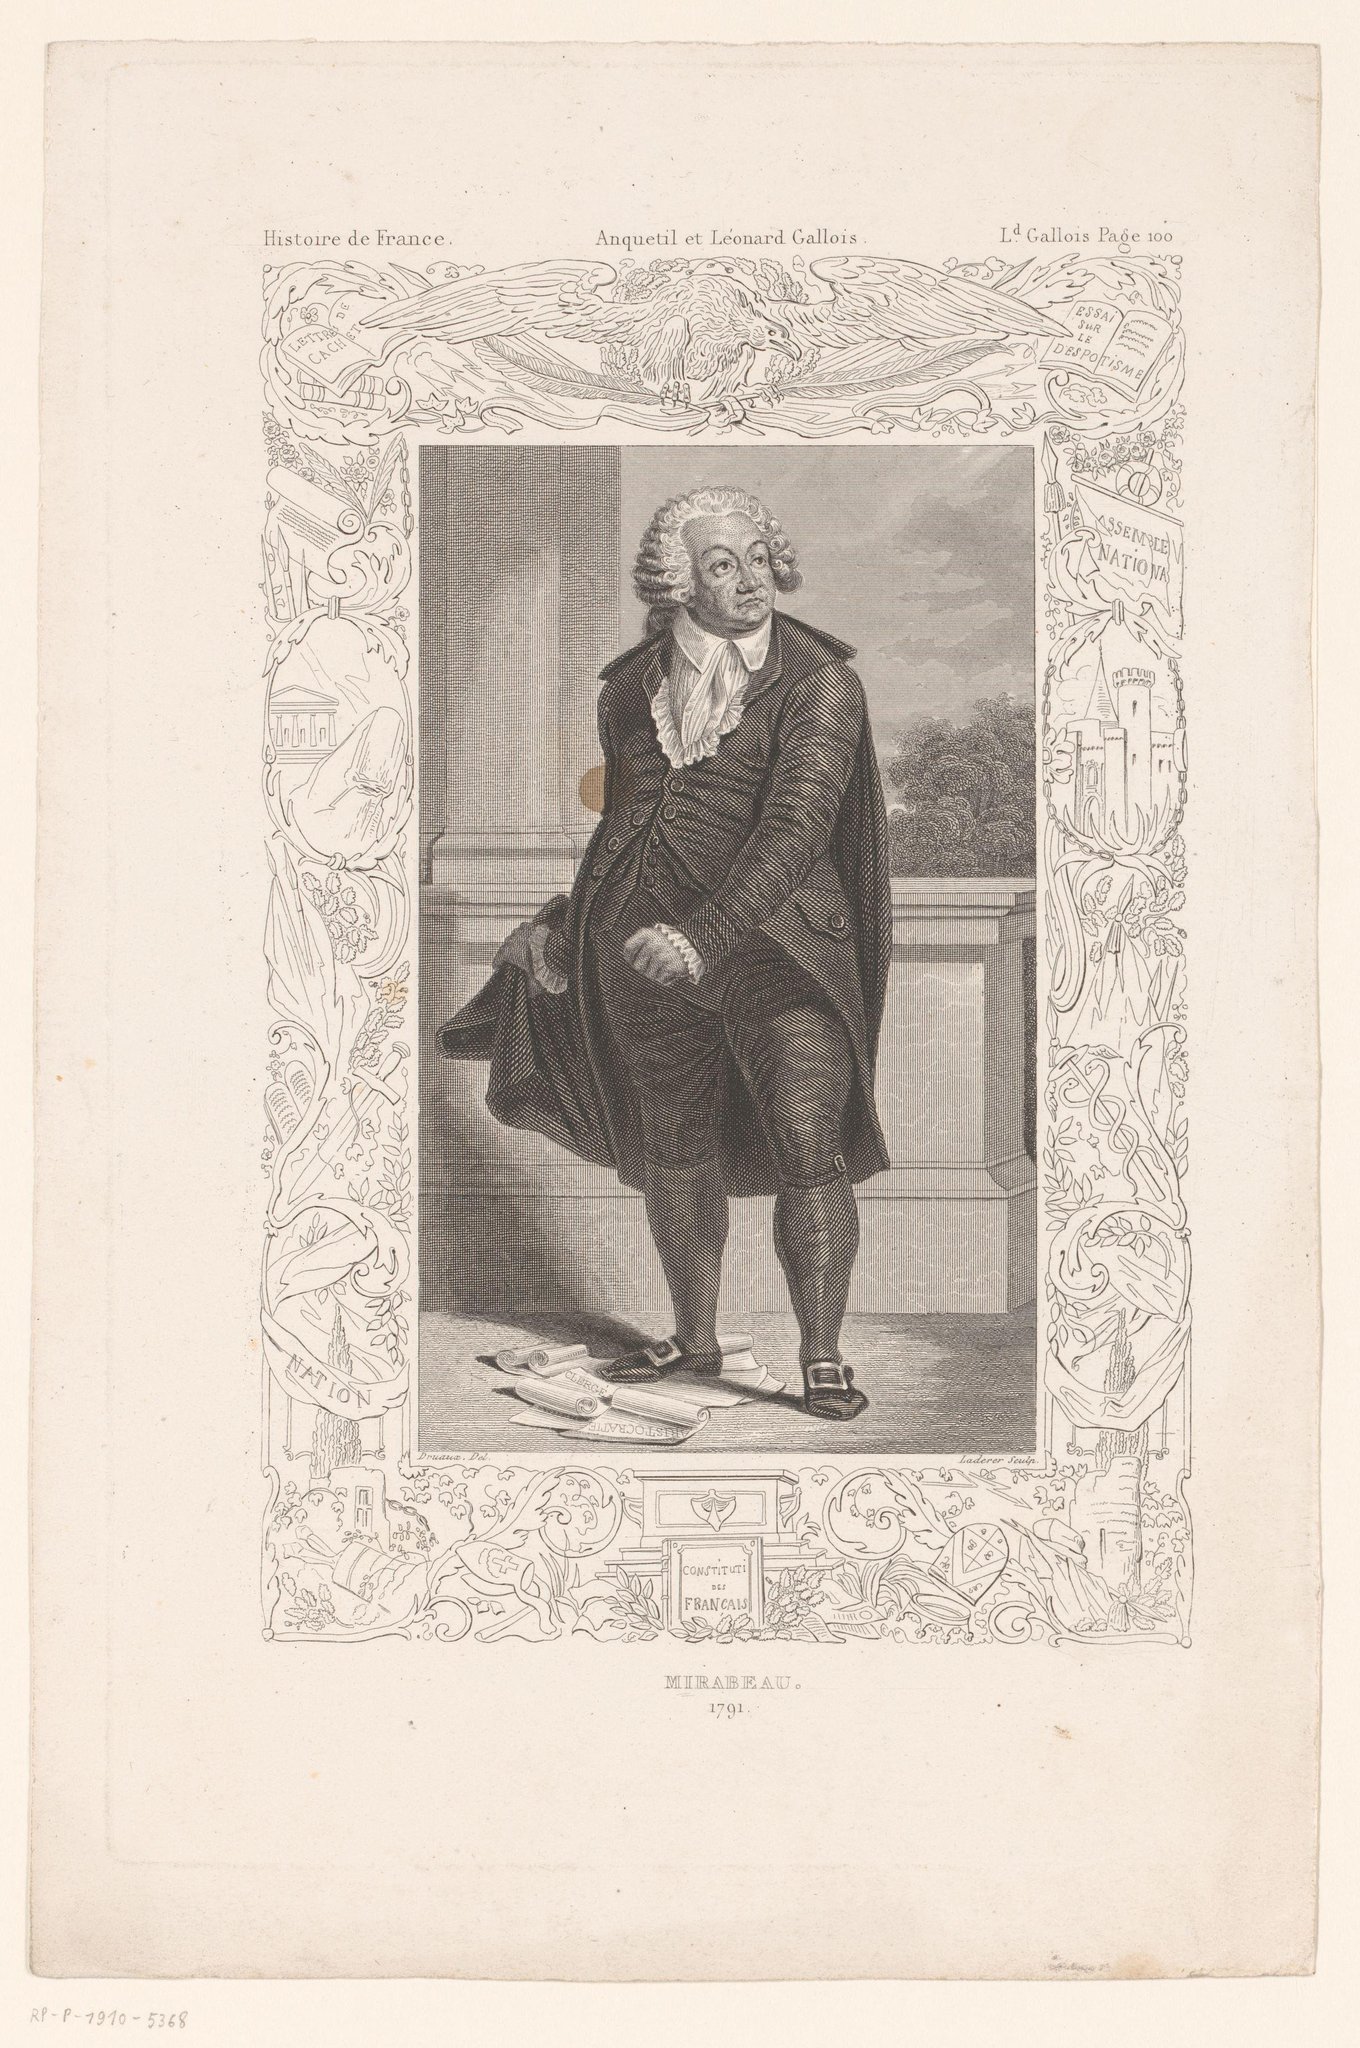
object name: print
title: Mirabeau.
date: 1791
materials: paper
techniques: etching, engraving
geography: france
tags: paris, politician, honoré-gabriel de riqueti (graaf van mirabeau), historical persons, portrait of a writer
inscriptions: collector's mark: Lugt 2228